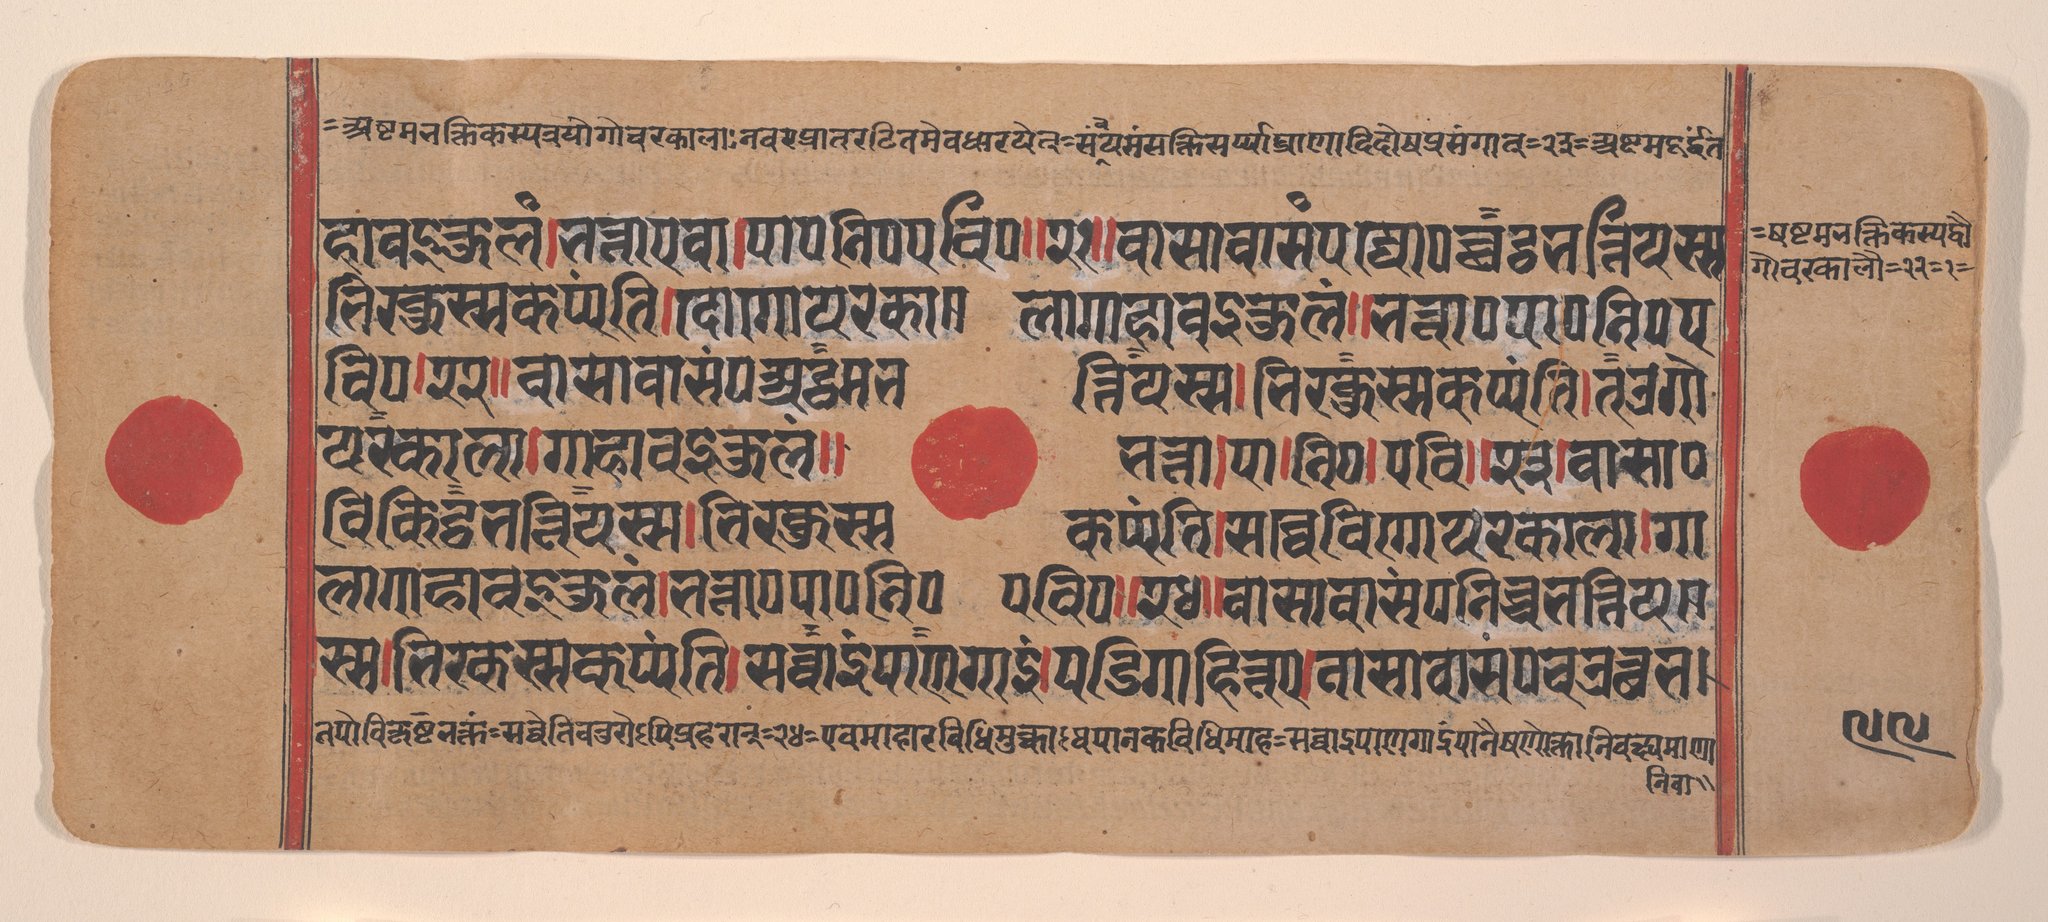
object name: folio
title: Page from a Dispersed Kalpa Sutra (Jain Book of Rituals)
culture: indian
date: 1401-1500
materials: gold, ink, paper, watercolor